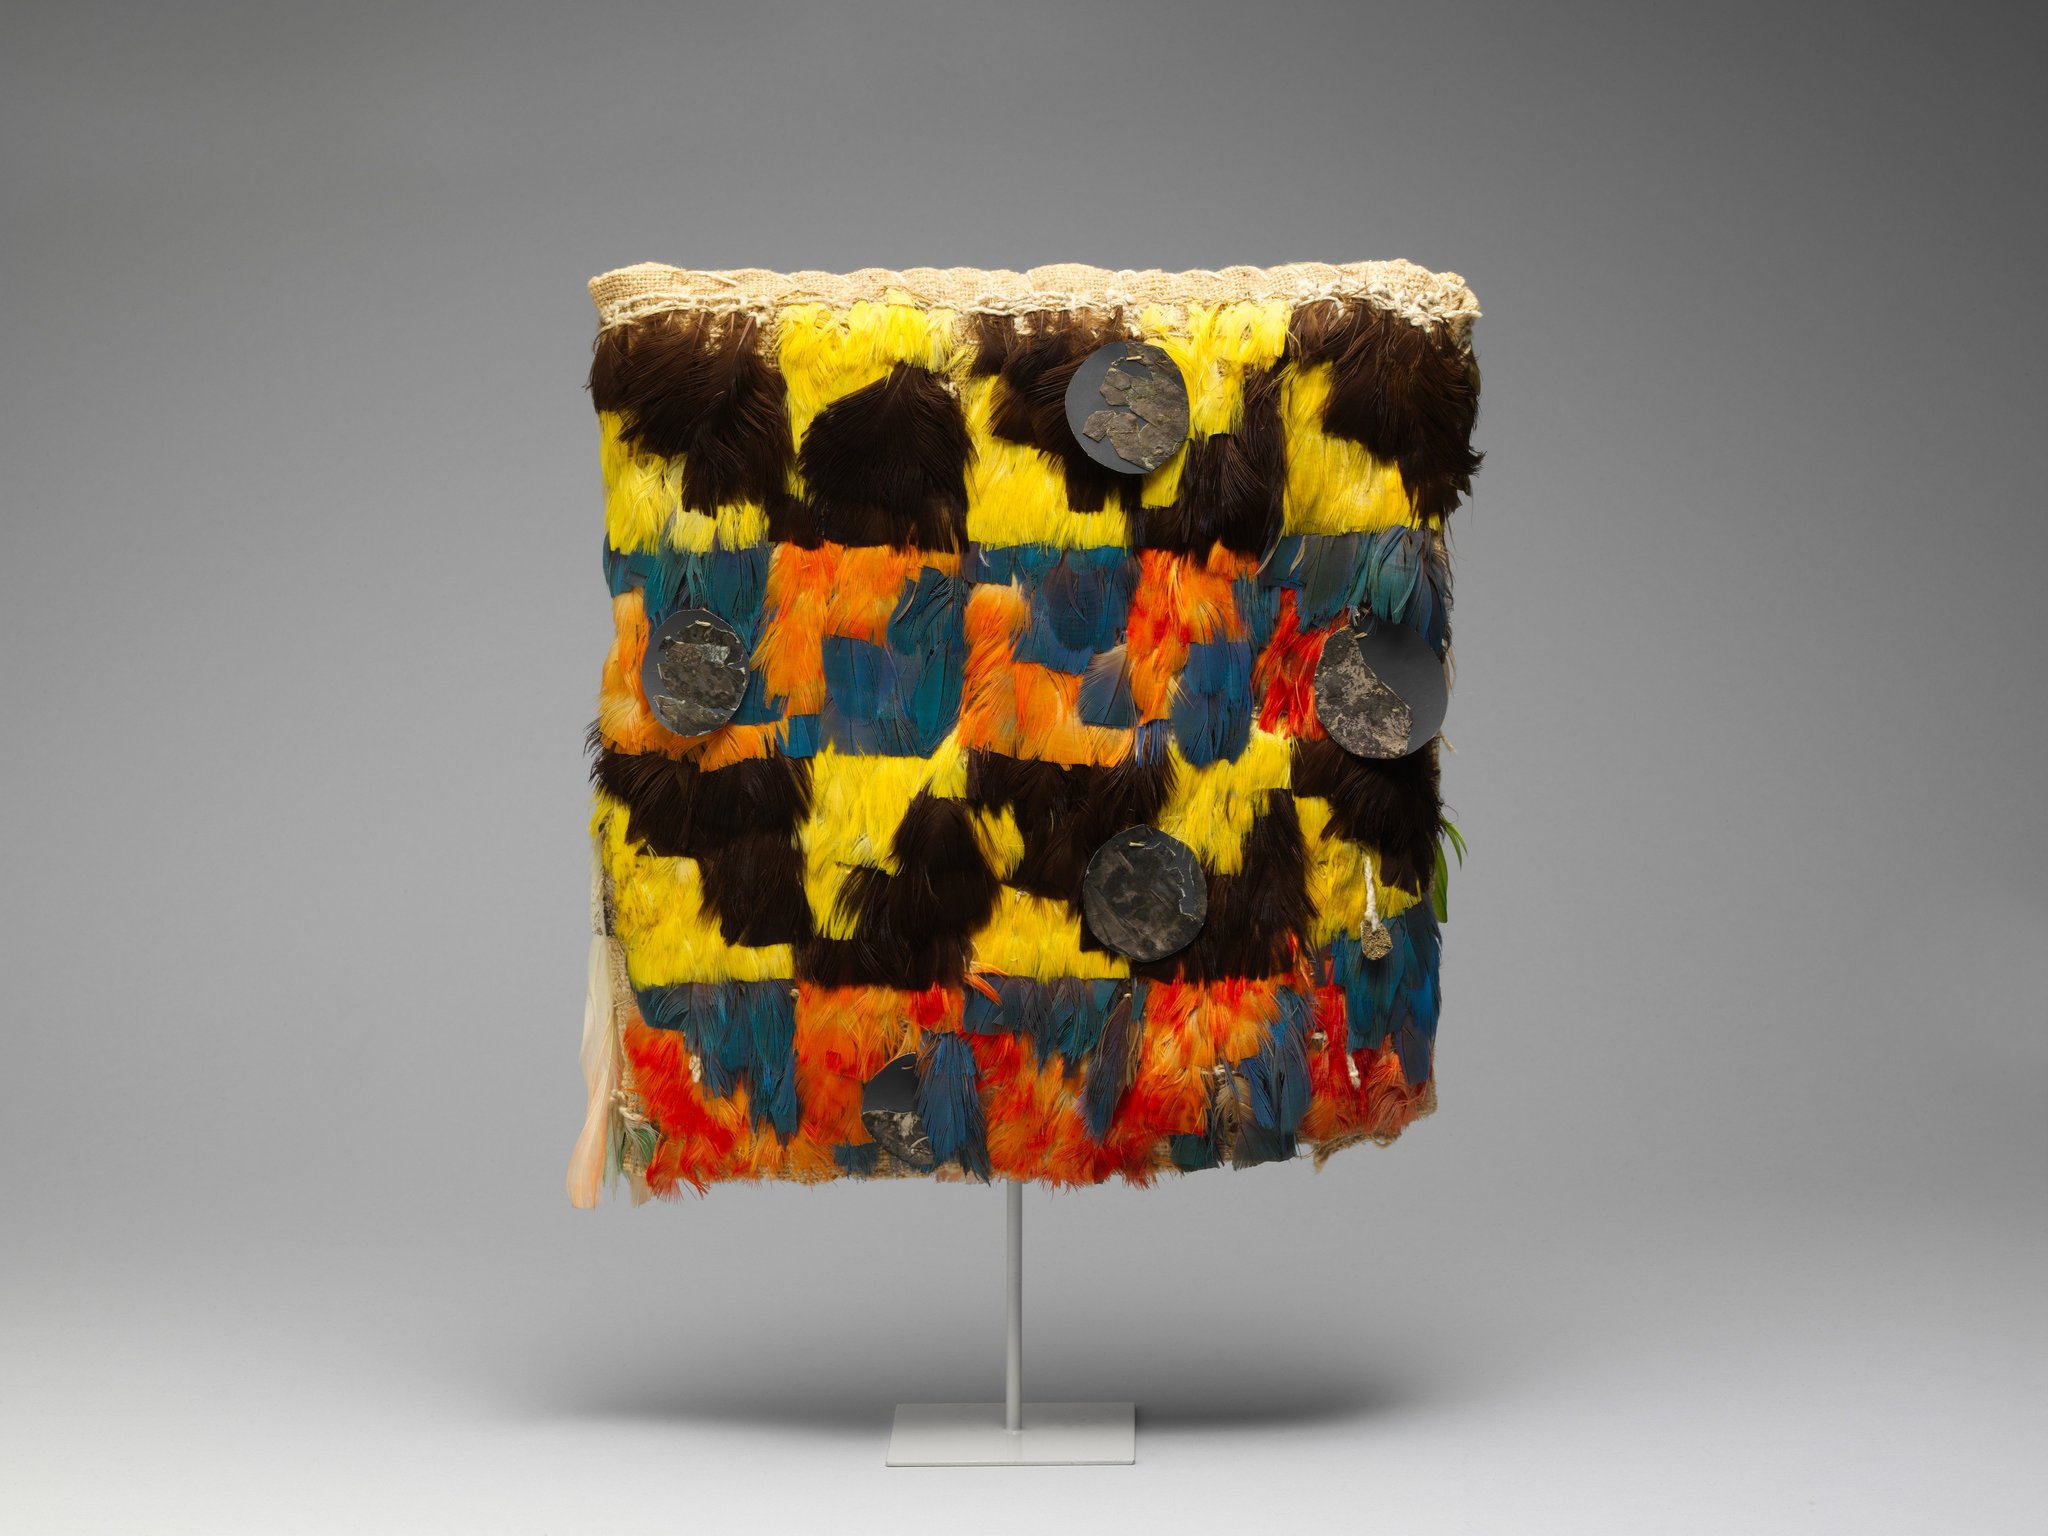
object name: miniature dress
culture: ica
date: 1101-1300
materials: cotton, feather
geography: peru